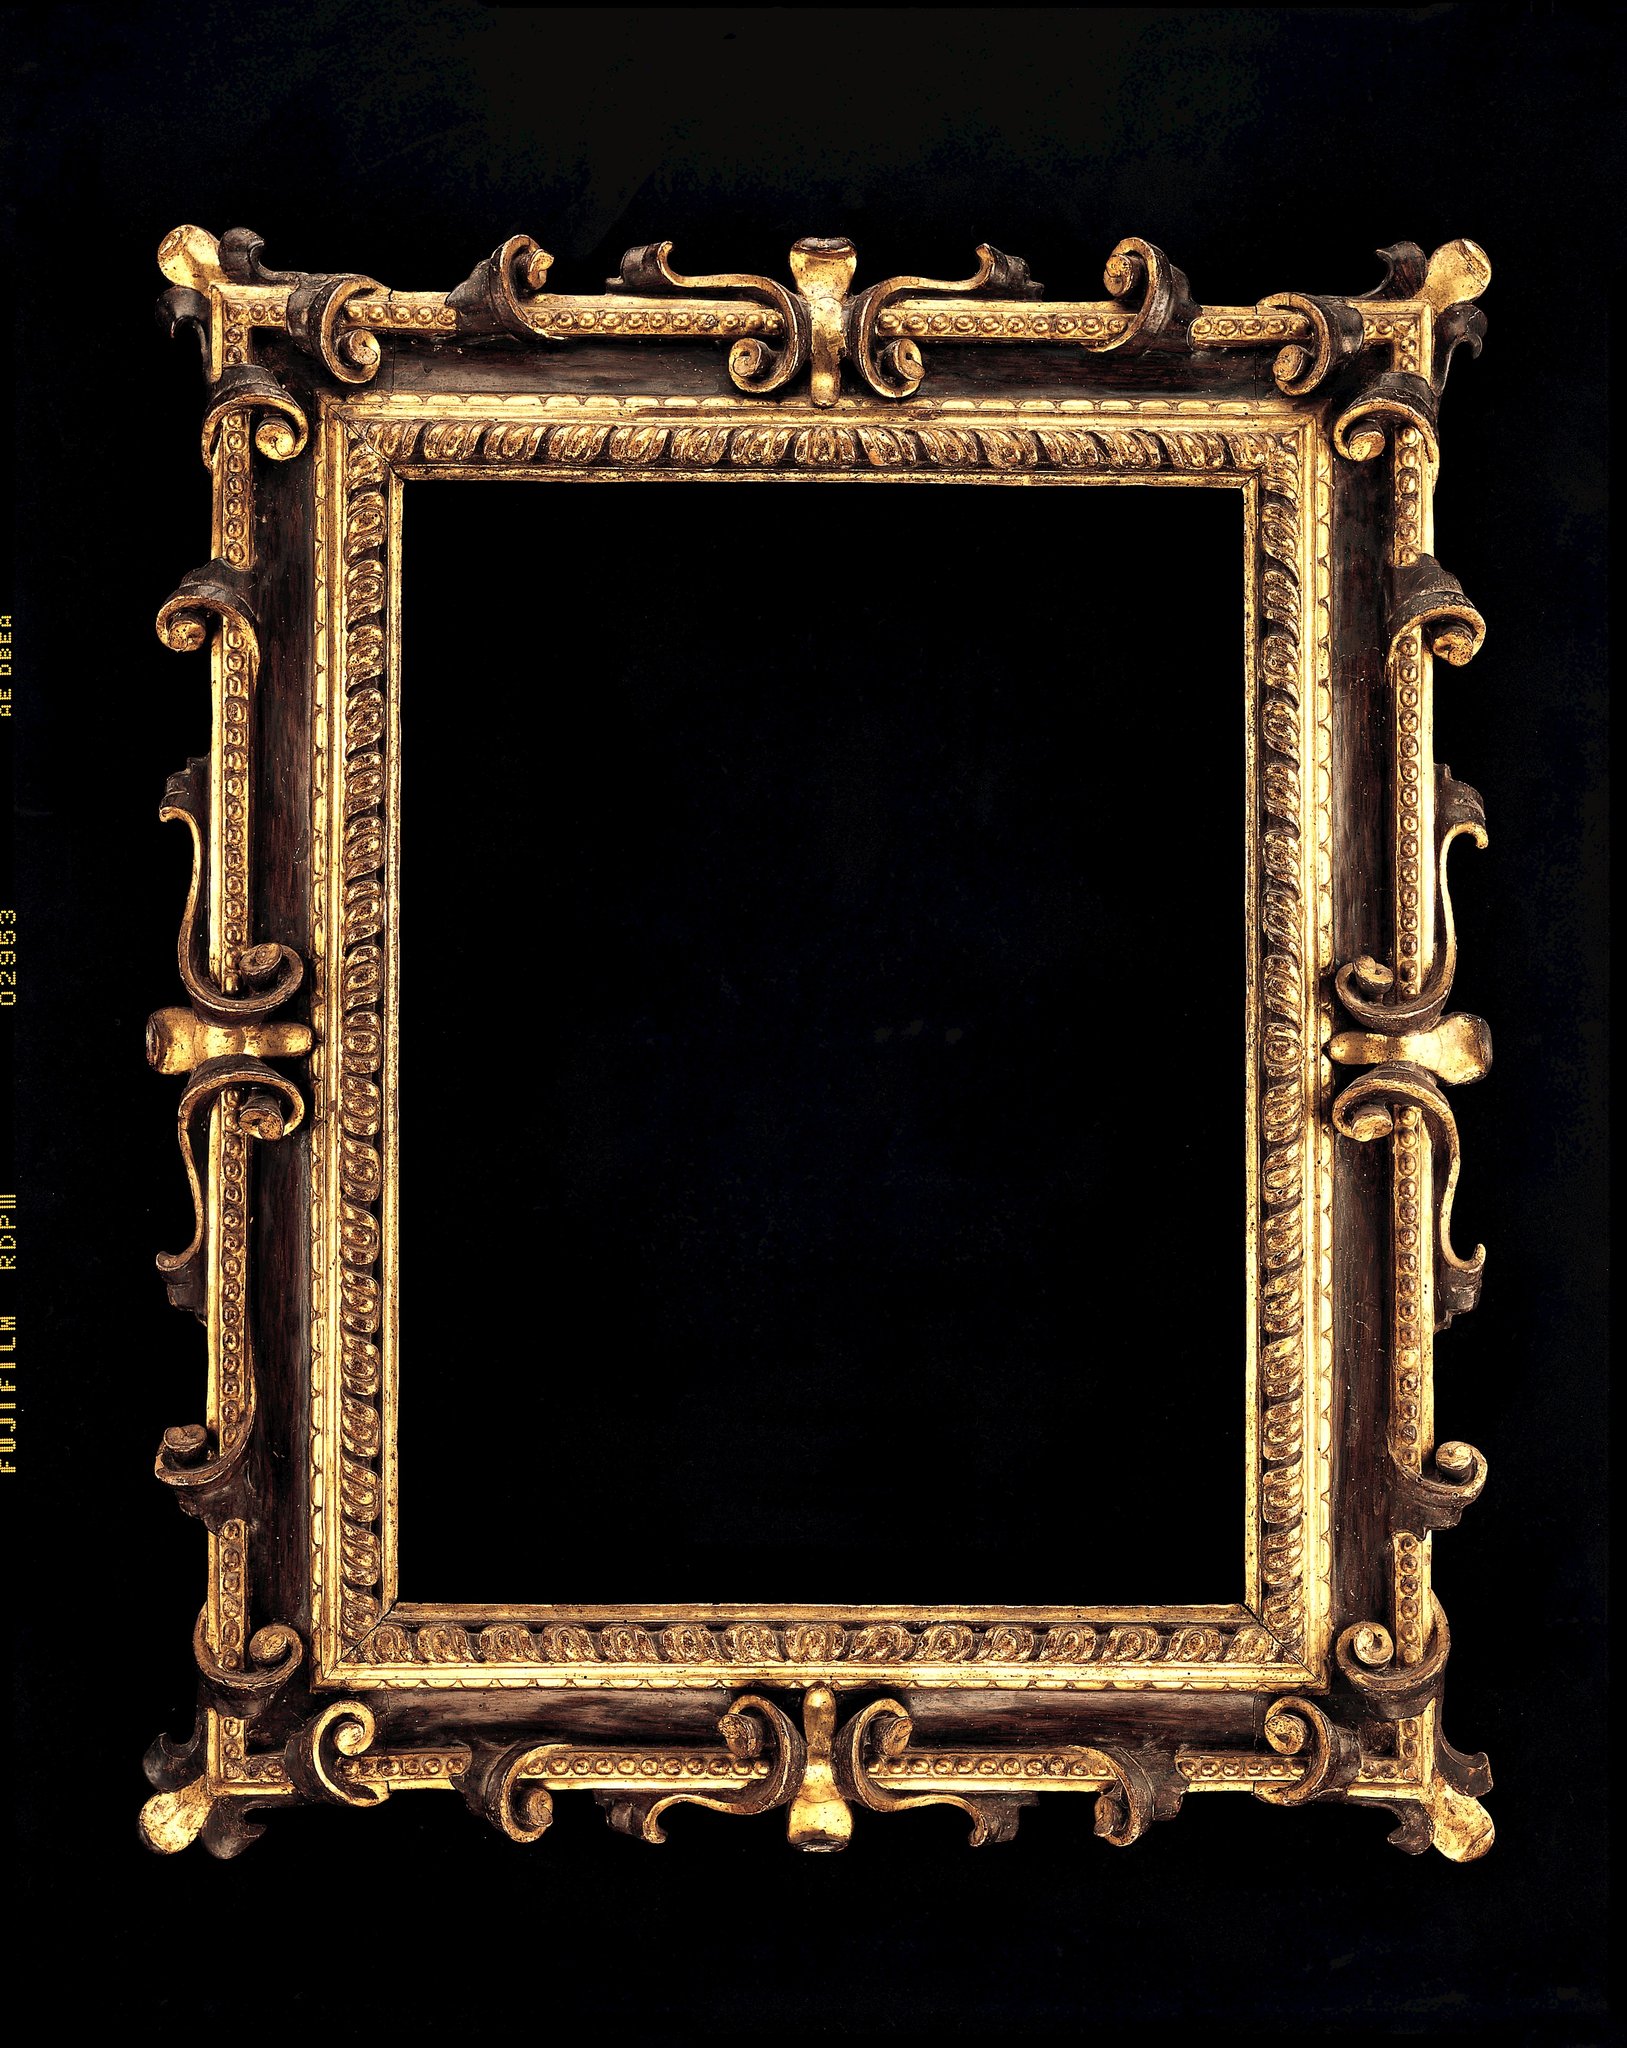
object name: frame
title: Reverse frame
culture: italian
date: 1600-1640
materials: wood